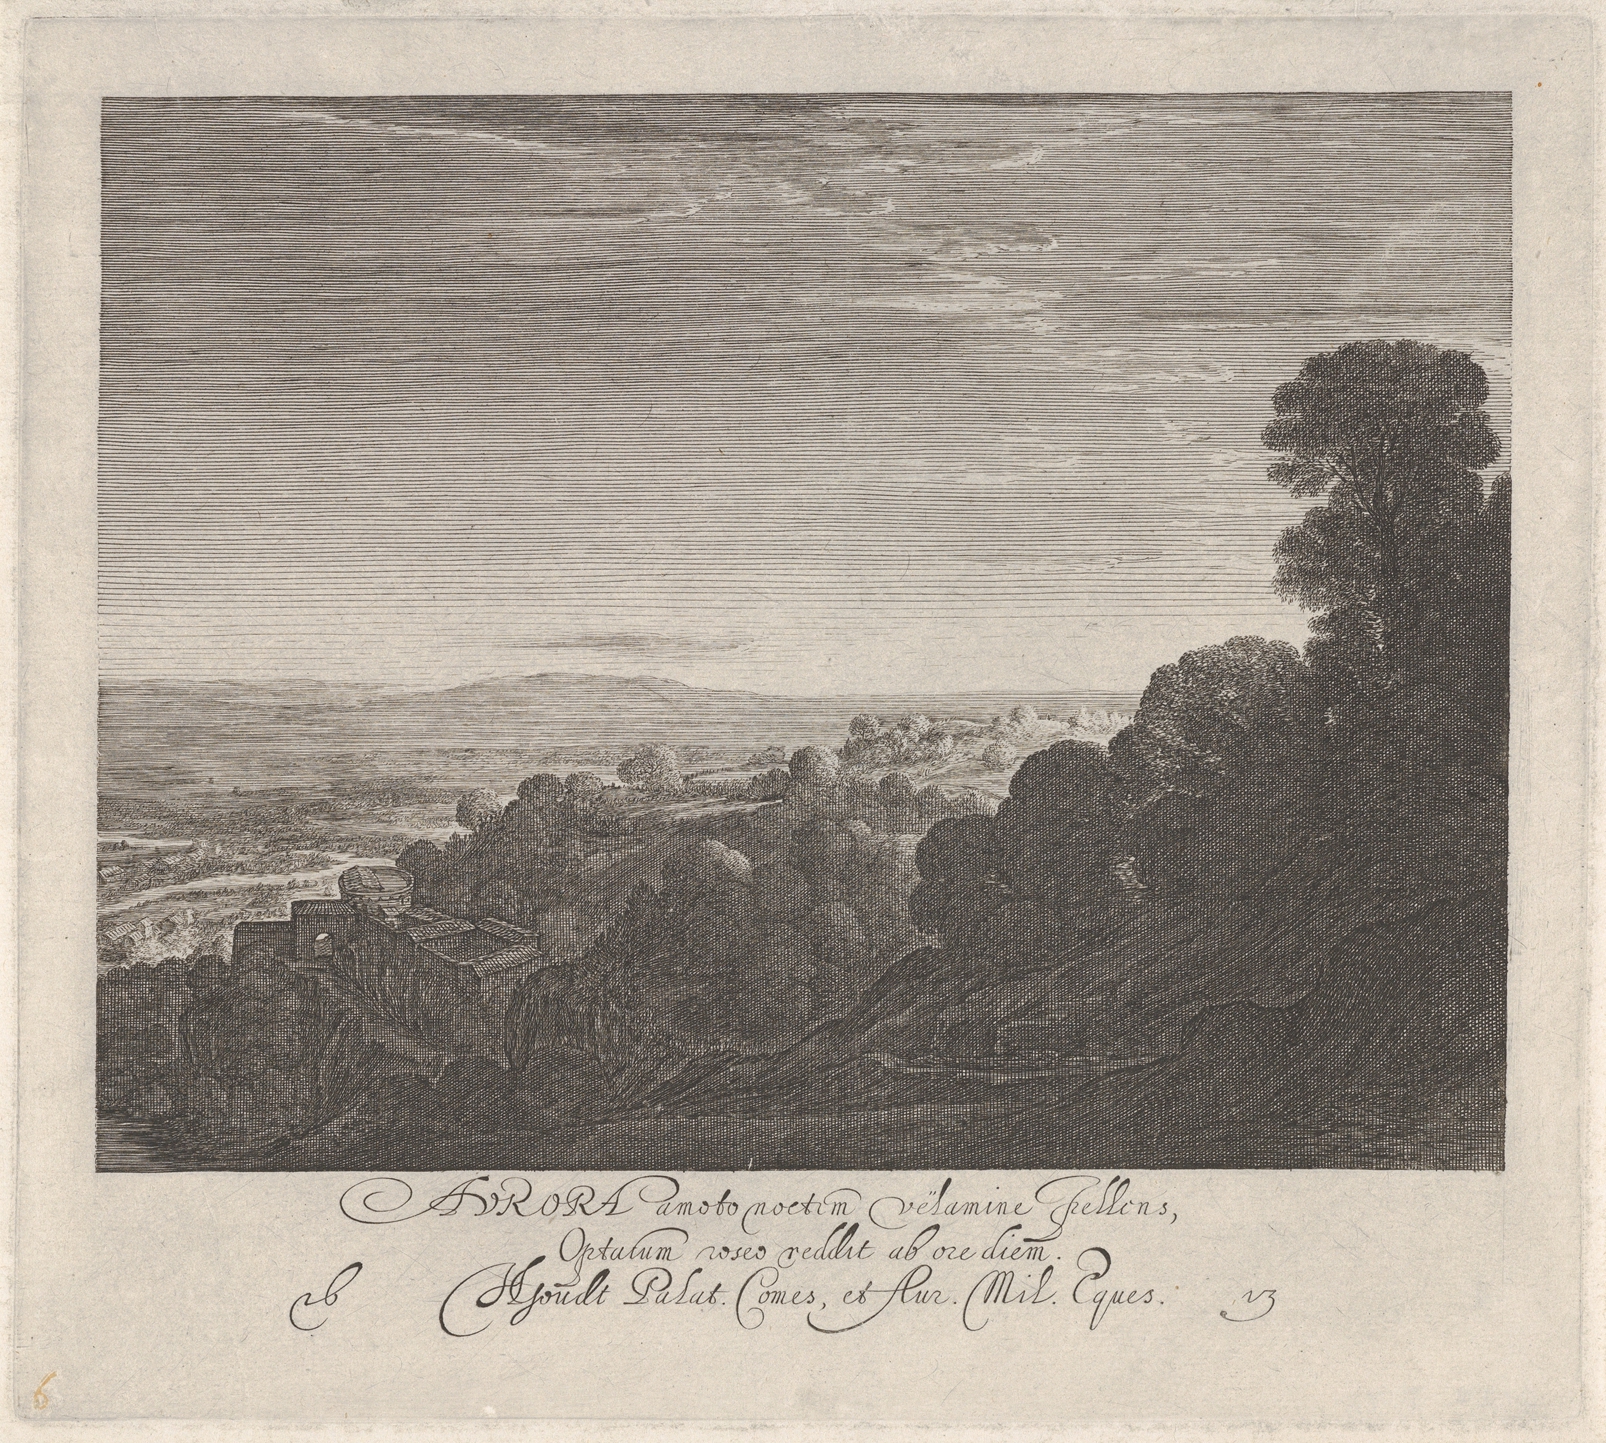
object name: print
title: Aurora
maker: hendrick goudt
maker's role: artist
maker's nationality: dutch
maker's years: 1580-1648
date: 1590-1648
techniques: engraving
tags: sky,landscapes,trees